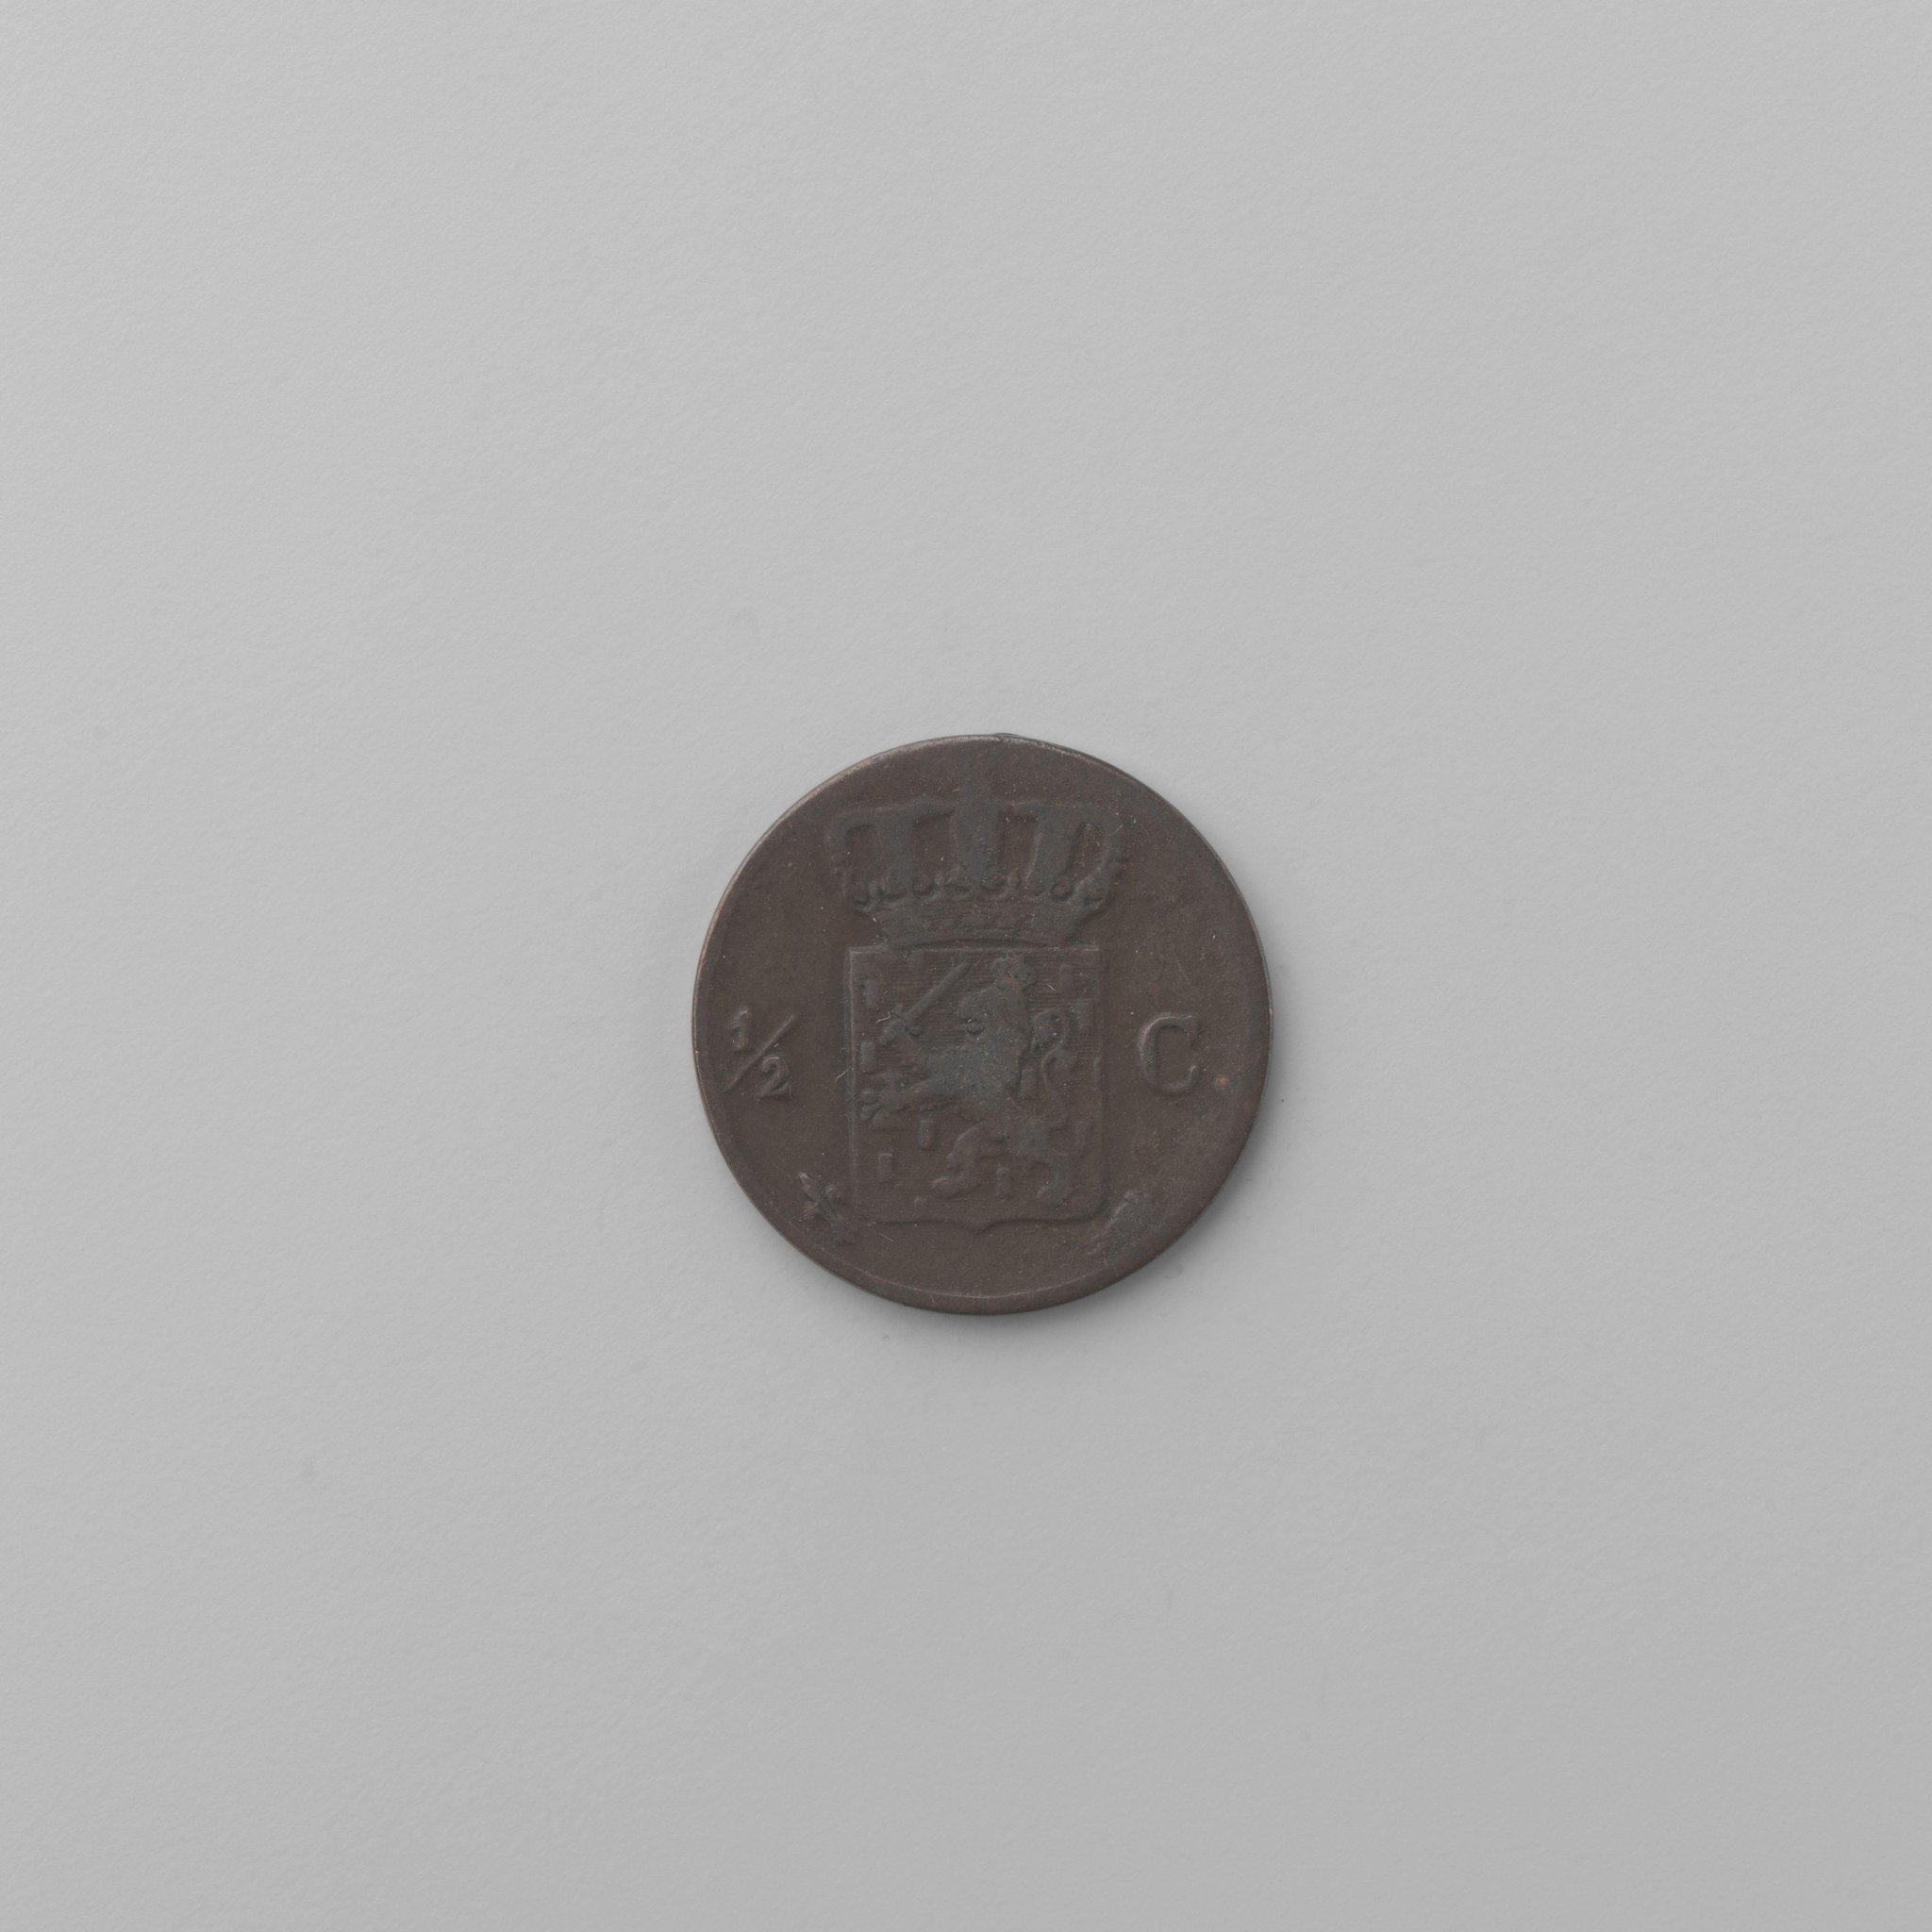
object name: coin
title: Nederlandse ½ cent, 1843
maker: william ii of the netherlands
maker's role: koning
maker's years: 1792-1849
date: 1843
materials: copper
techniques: striking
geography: utrecht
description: Koperen munt. Voorzijde: tussen jaartal gekroonde rechte letter W. Keerzijde: tussen waarde-aanduiding ½ C. gekroond rijkswapenschild. Gladde rand.